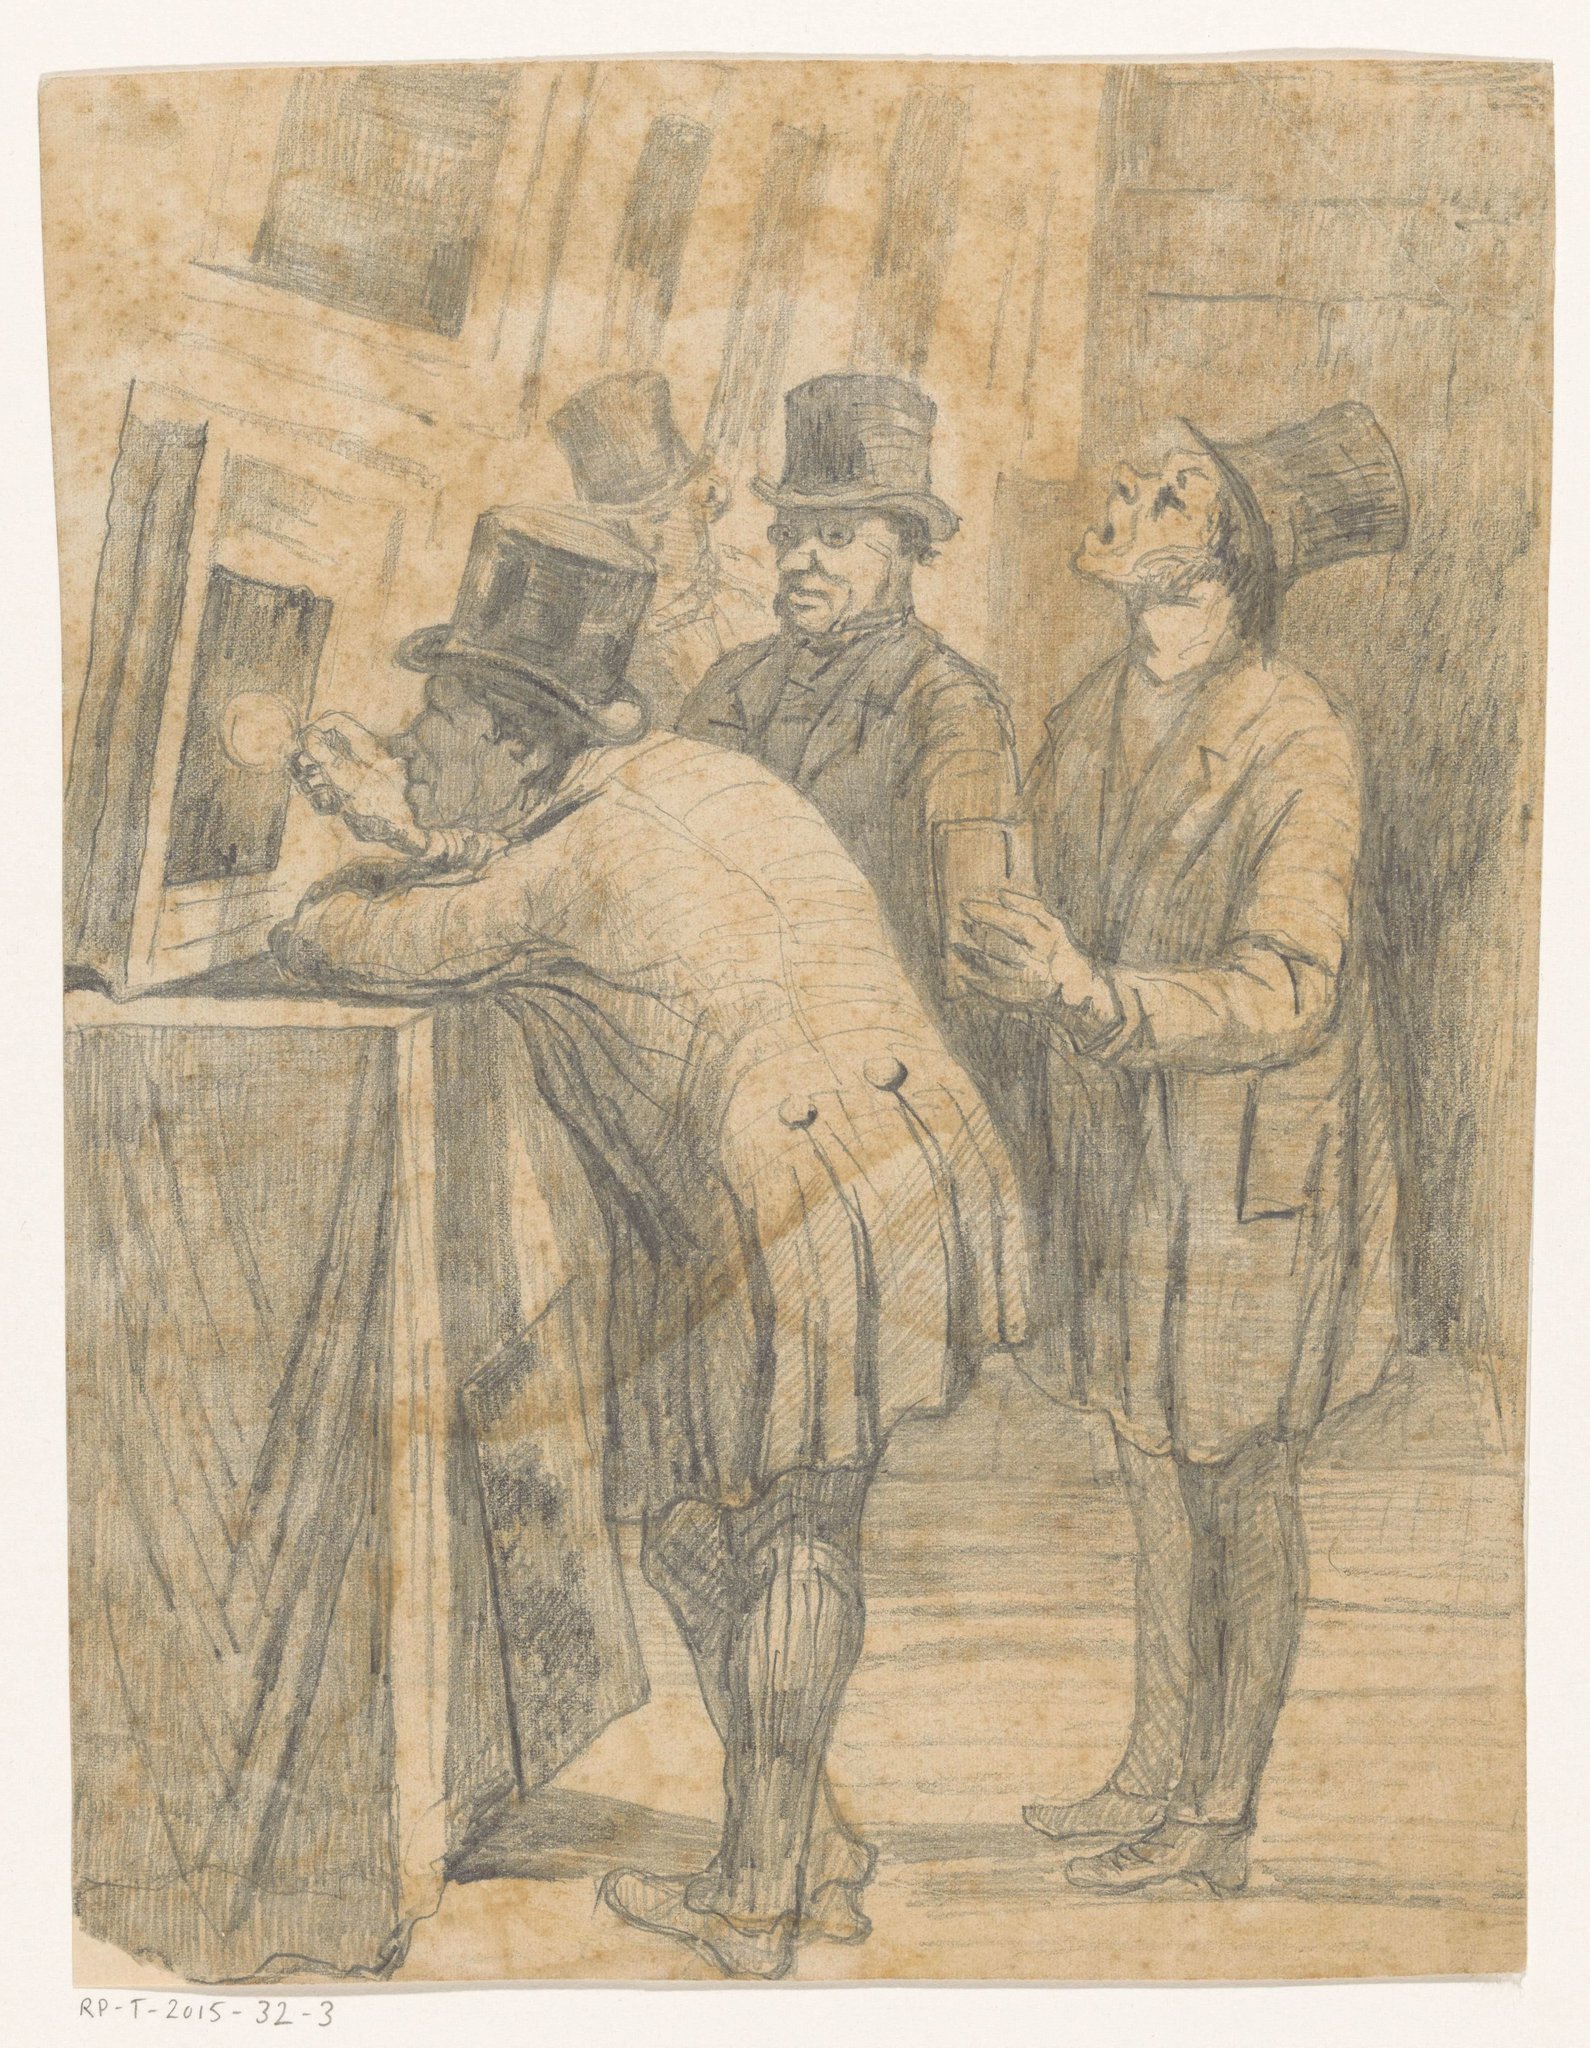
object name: drawing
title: Man bekijkt een schilderij of prent met een vergrootglas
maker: Anonymous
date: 1800-1899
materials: paper, pencil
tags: art collection, art gallery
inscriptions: collector's mark: Lugt 4779, collector's mark: Lugt 2228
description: In een salon of kunsthandel bestudeert een man een prent of schilderij aan de muur met een vergrootglas. Over zijn schouders kijken twee andere mannen met hem mee. Op de achtergrond een vierde figuur.